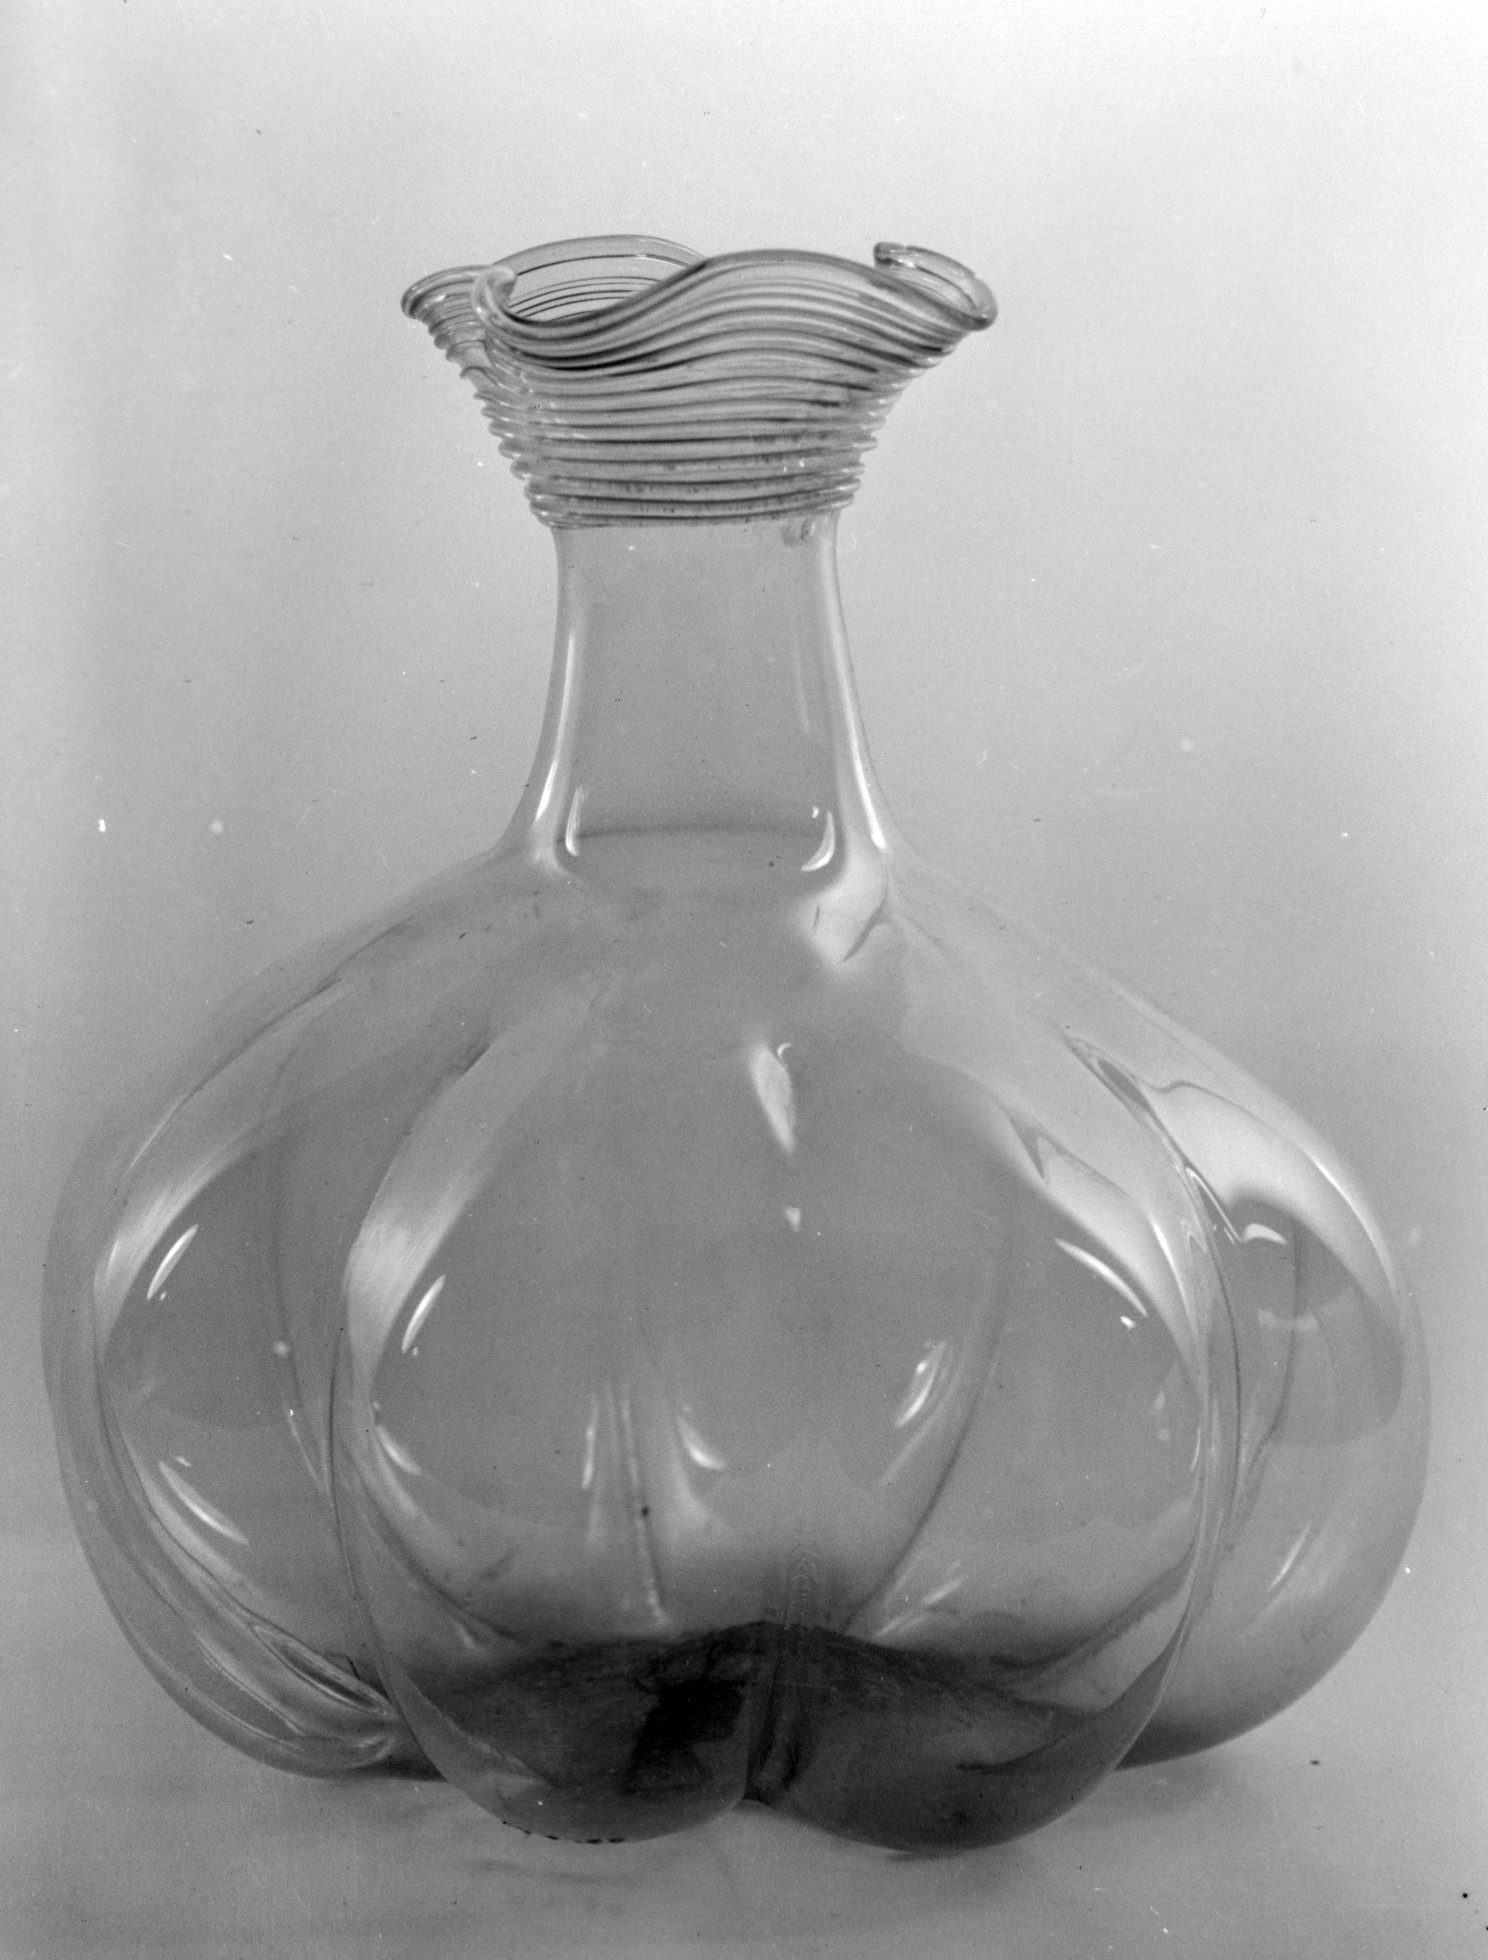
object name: flask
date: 1601-1700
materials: glass